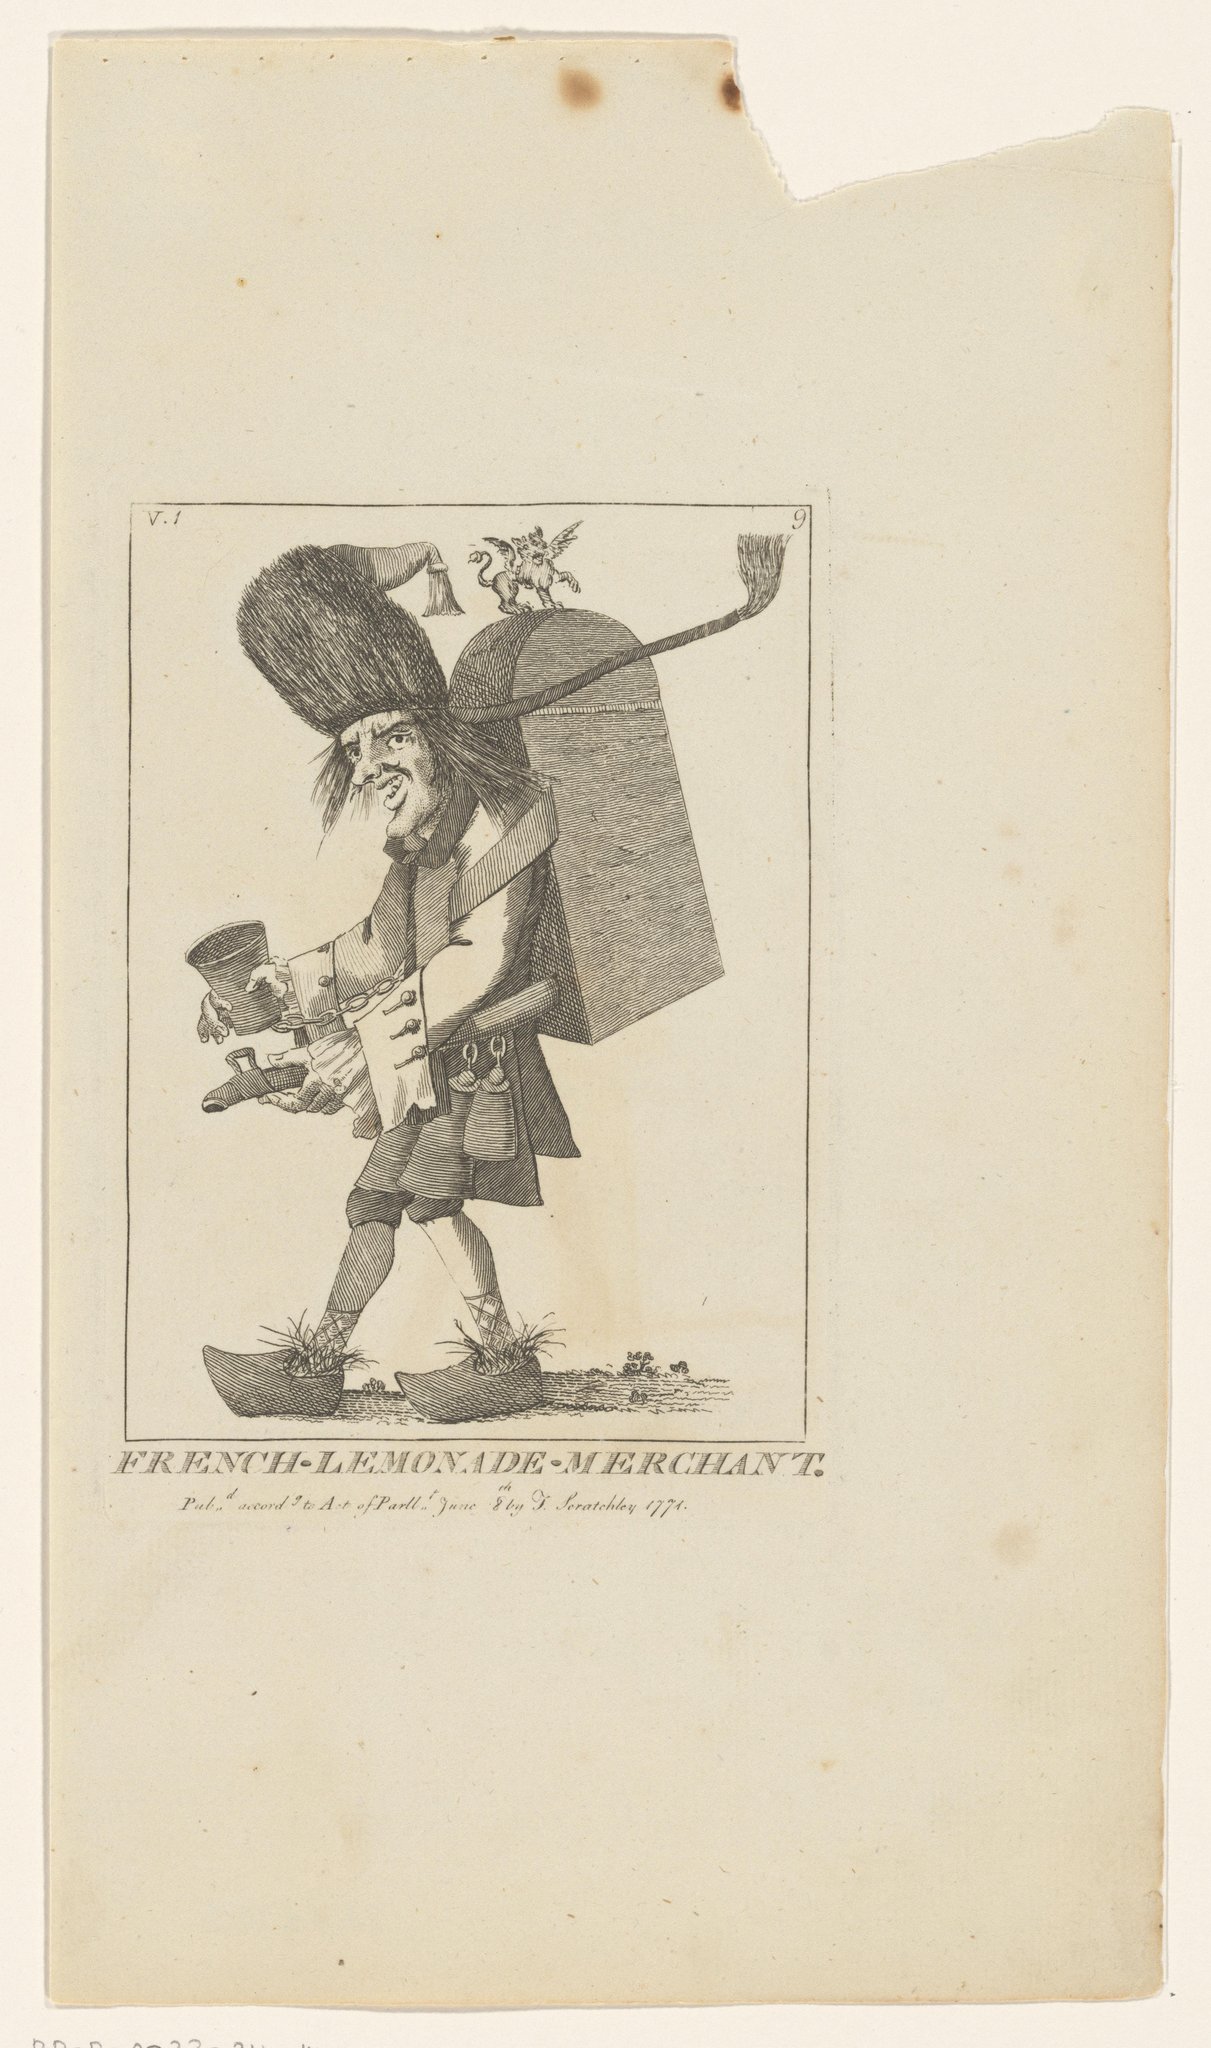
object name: cartoon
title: French Lemonade-Merchant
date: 1771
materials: paper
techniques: etching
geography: london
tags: caricatures (human types), wooden shoes, clogs, europeans: french (+ caricatured), styles of hairdress, street-trader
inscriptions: collector's mark: Lugt 2228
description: Een karikaturale voorstelling van een staande man met het gezicht naar links en een tank op zijn rug waaruit hij in een metalen beker giet. Op zijn hoofd draagt hij een grote bontmuts, aan zijn voeten grote klompen gevuld met stro. Zijn lange haren vallen los van voren en zijn samengebonden in een lange vlecht van achteren. Prent nummer 9 uit de eerste van zes sets van elk 24 karikaturen van verschillende dames, heren, kunstenaars, enz., uitgegeven door de Darly’s.